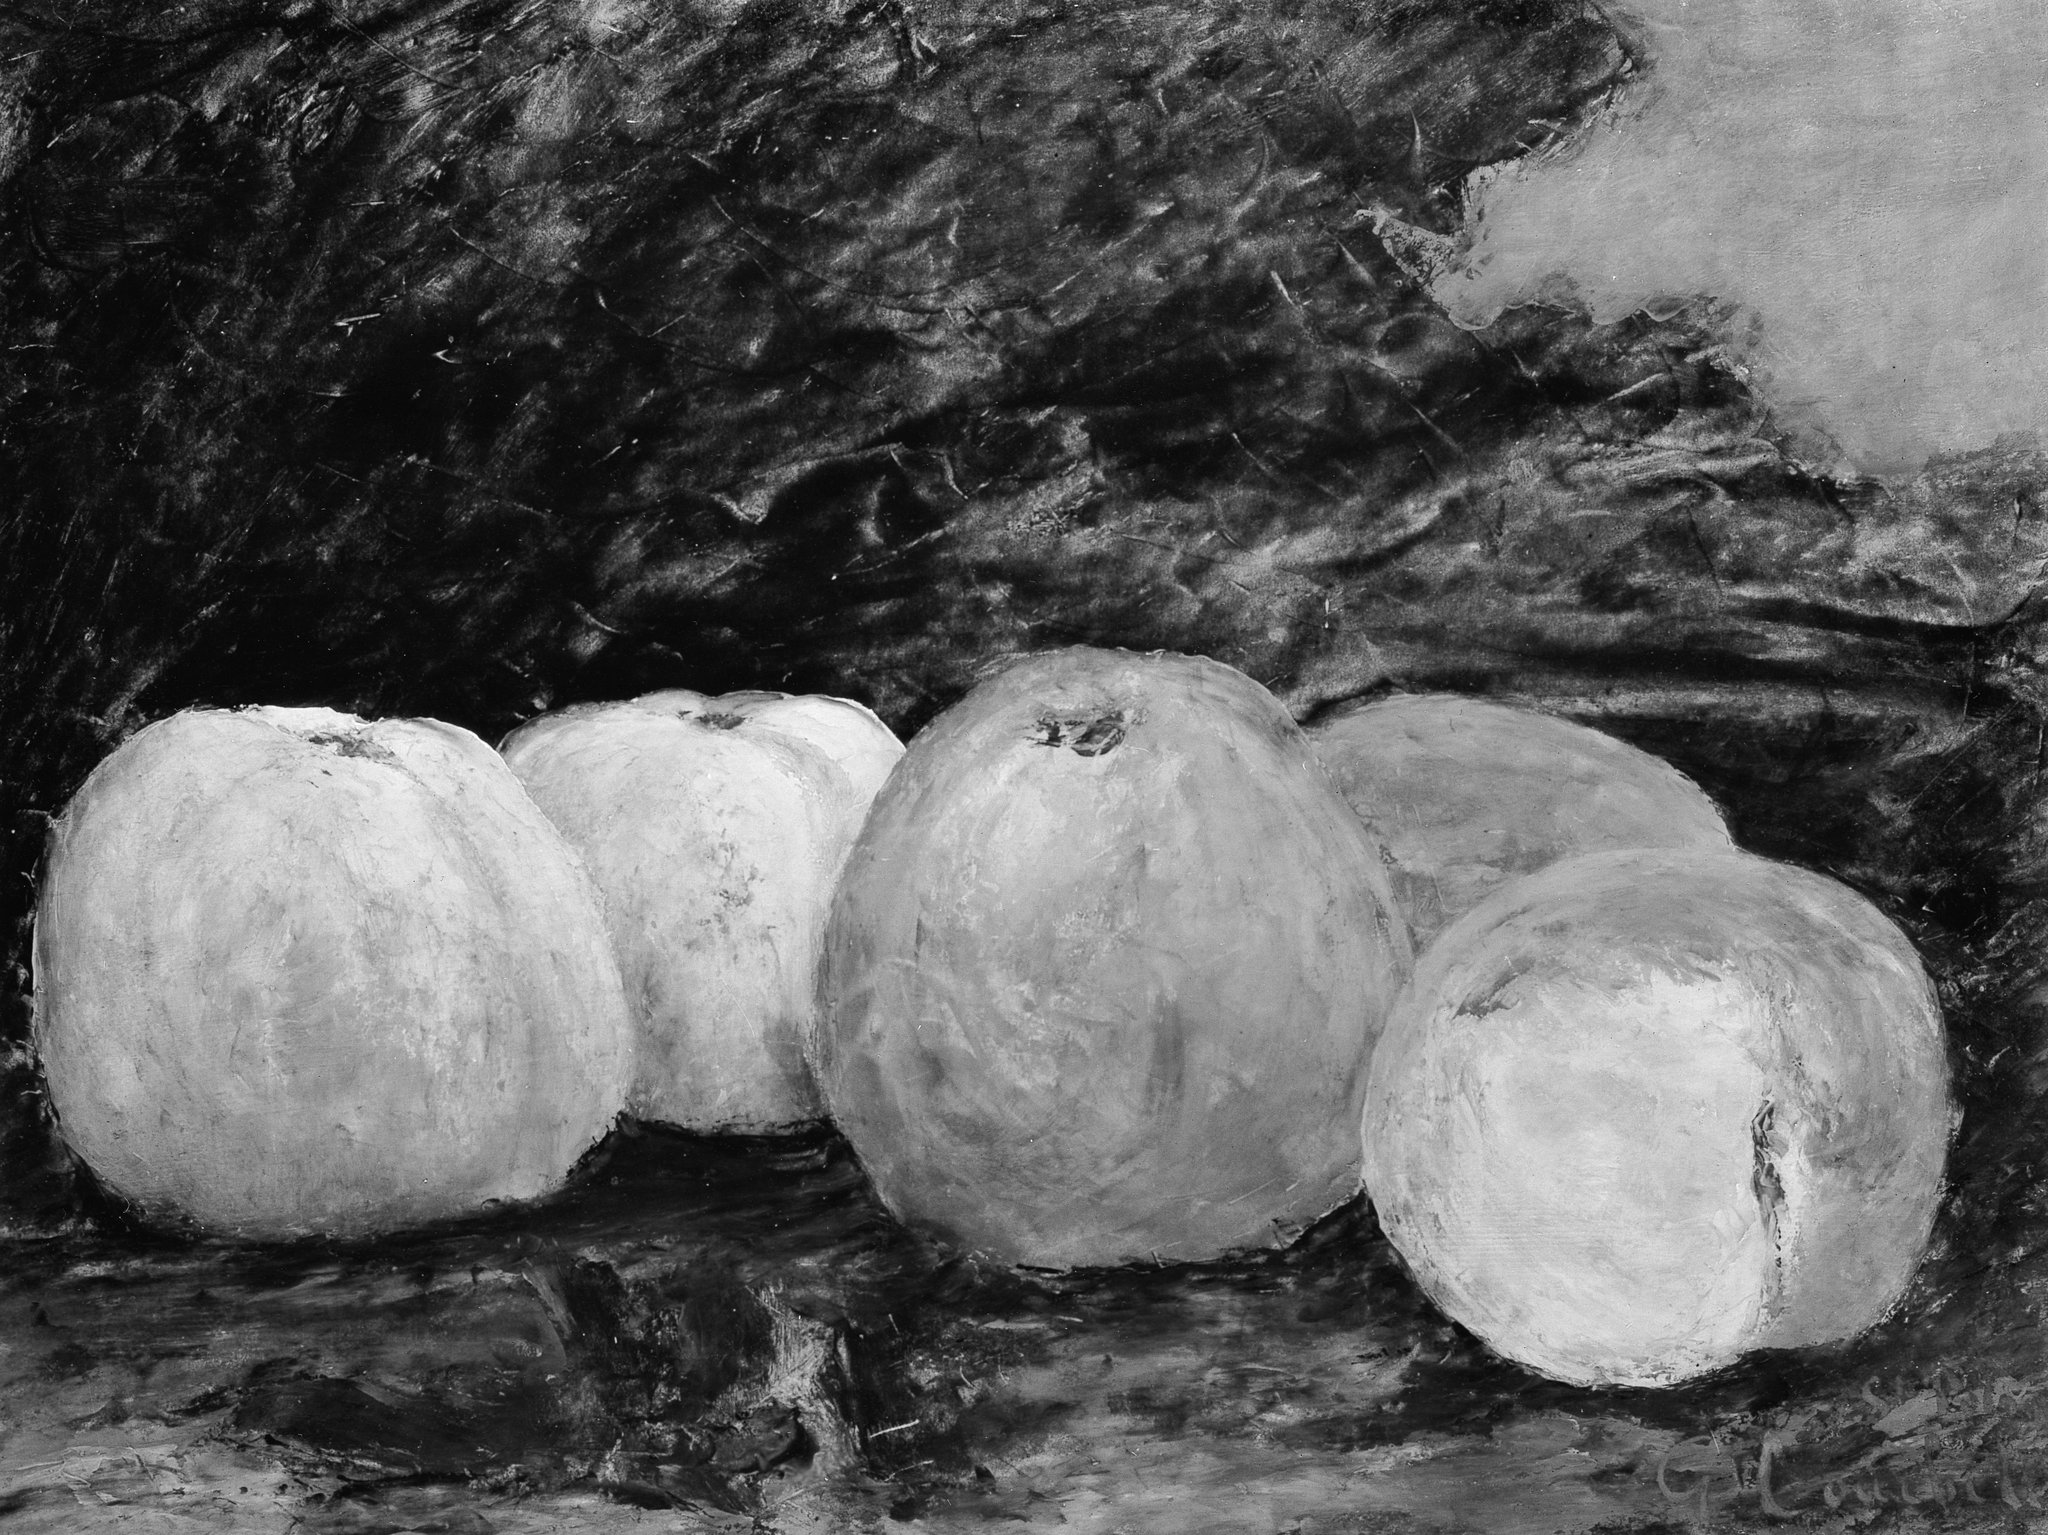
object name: painting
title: Apples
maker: gustave courbet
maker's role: artist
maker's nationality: french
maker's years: 1819-1877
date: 1850-1899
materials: canvas, oil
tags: apples